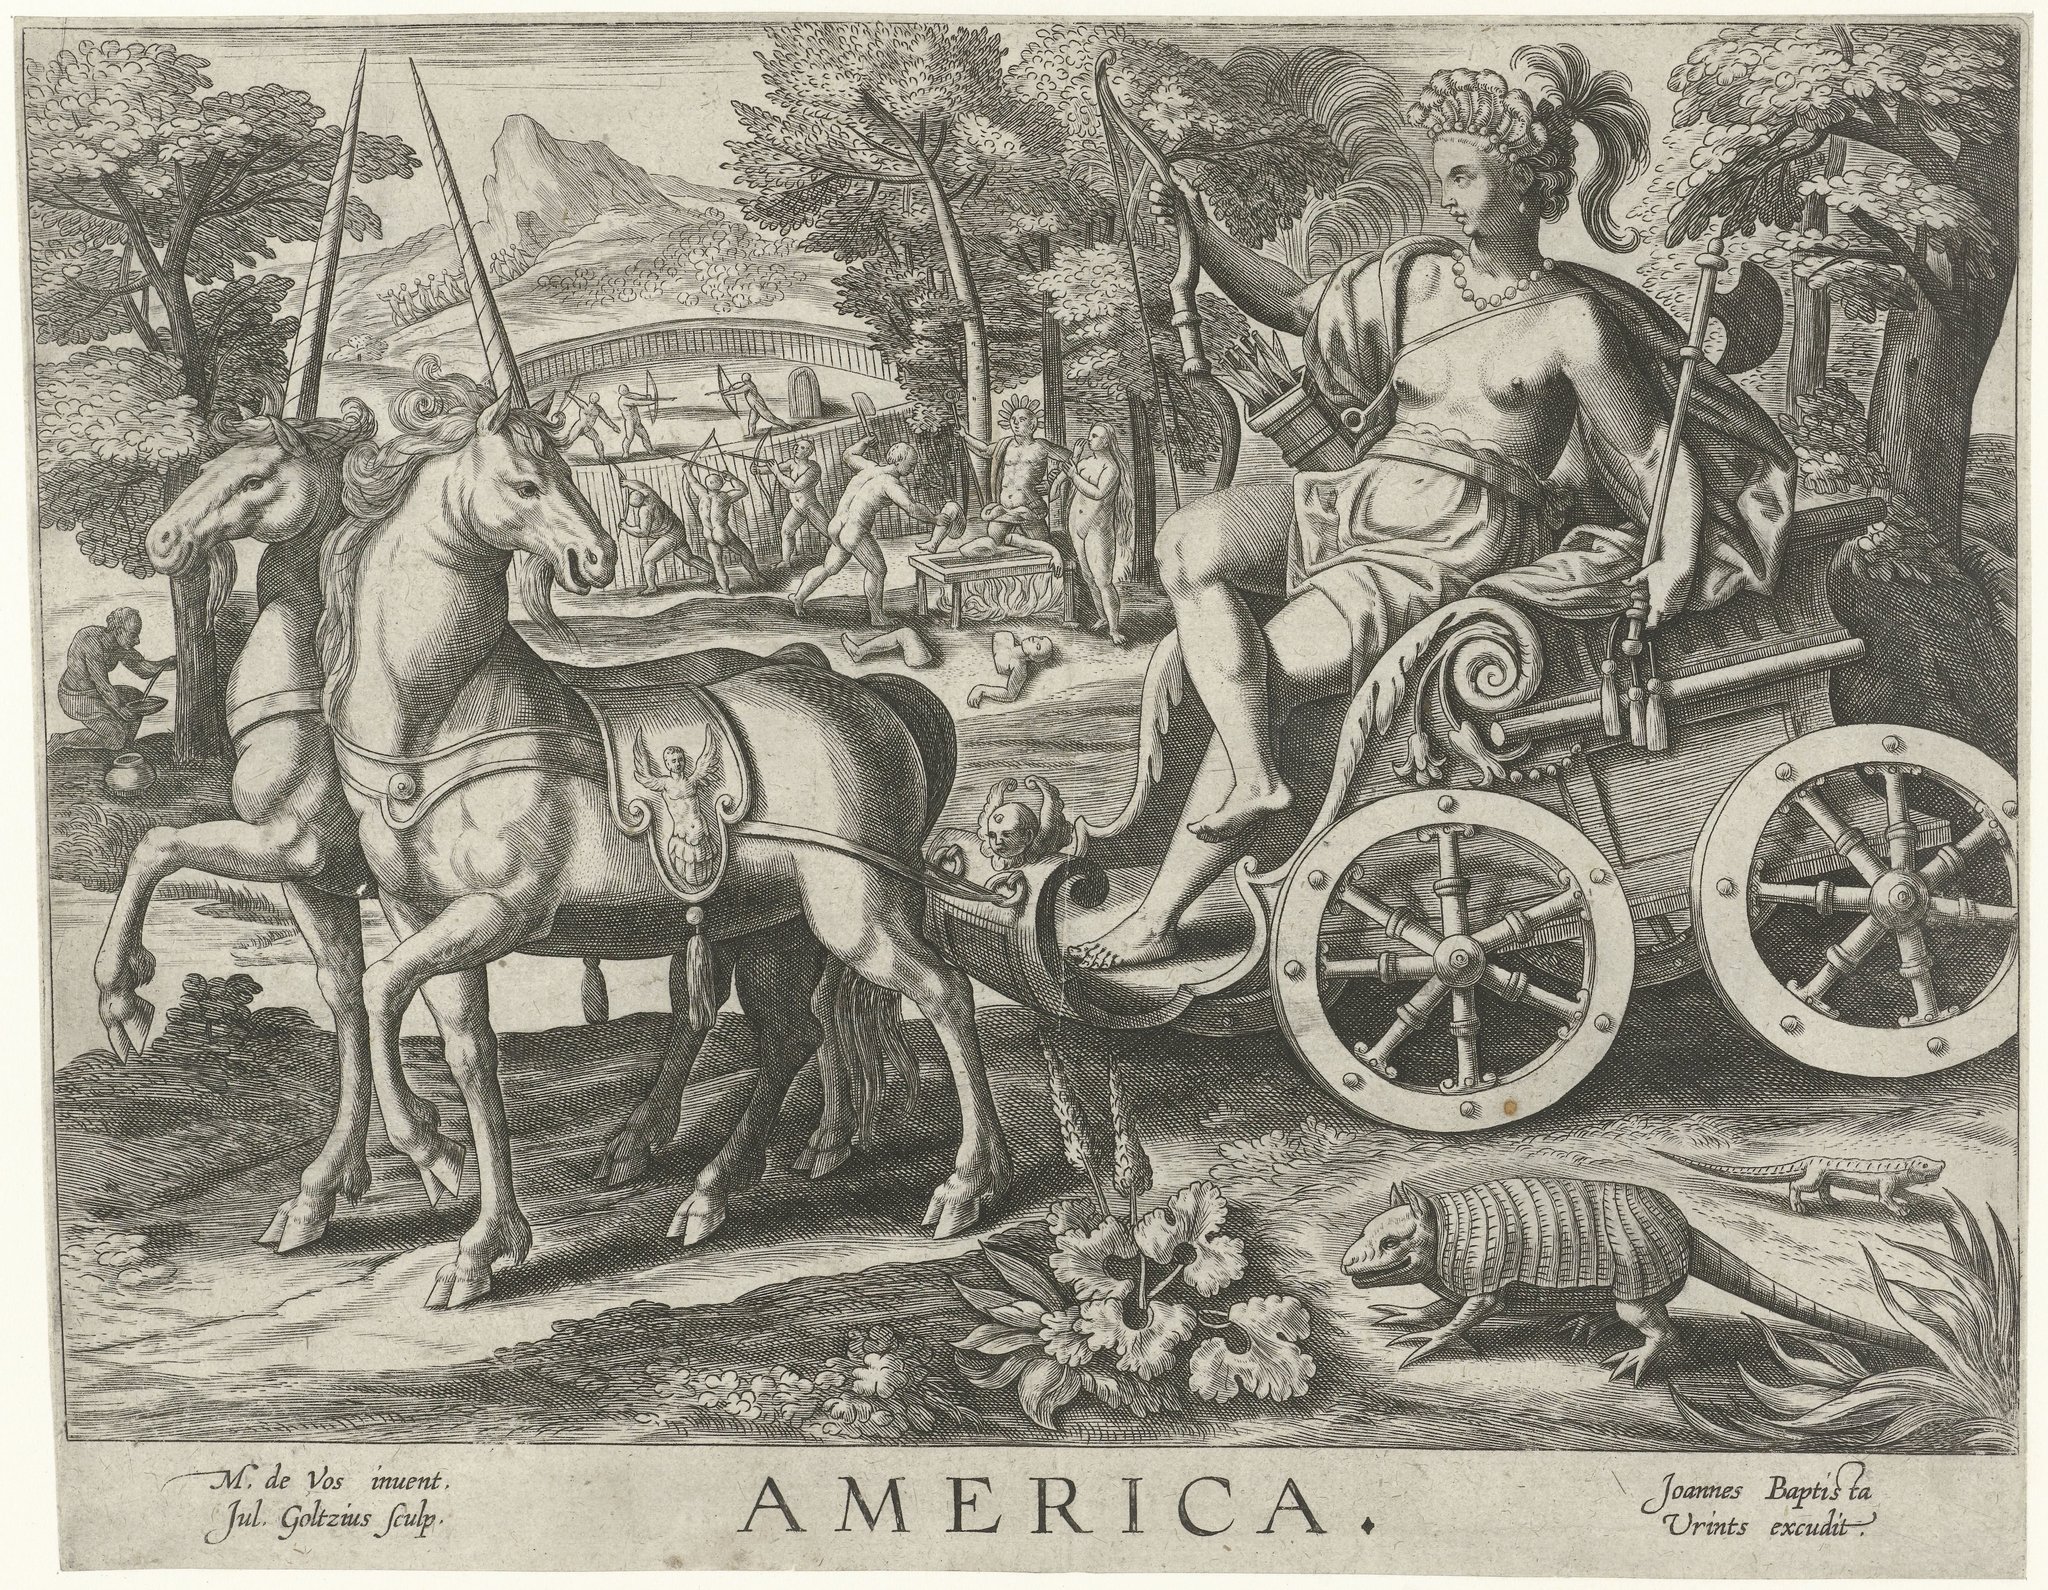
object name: print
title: America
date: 1575-1610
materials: paper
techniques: engraving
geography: antwerp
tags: unicorn, america represented allegorically; 'america' (ripa), other mammals: armadillo, native peoples of the americas, cannibalism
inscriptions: collector's mark: Lugt 2228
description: De vrouwelijke personificatie van het continent Amerika zit met pijl-en-boog in een kar, getrokken door twee eenhoorns. Naast de kar een reuzengordeldier en een hagedis. Op de achtergrond slachten kannibalen een man en roosteren hem boven een vuur. Nog verder naar achteren schieten mannen met pijl en boog op elkaar. De prent is deel van een vierdelige serie met personificaties van de vier continenten.